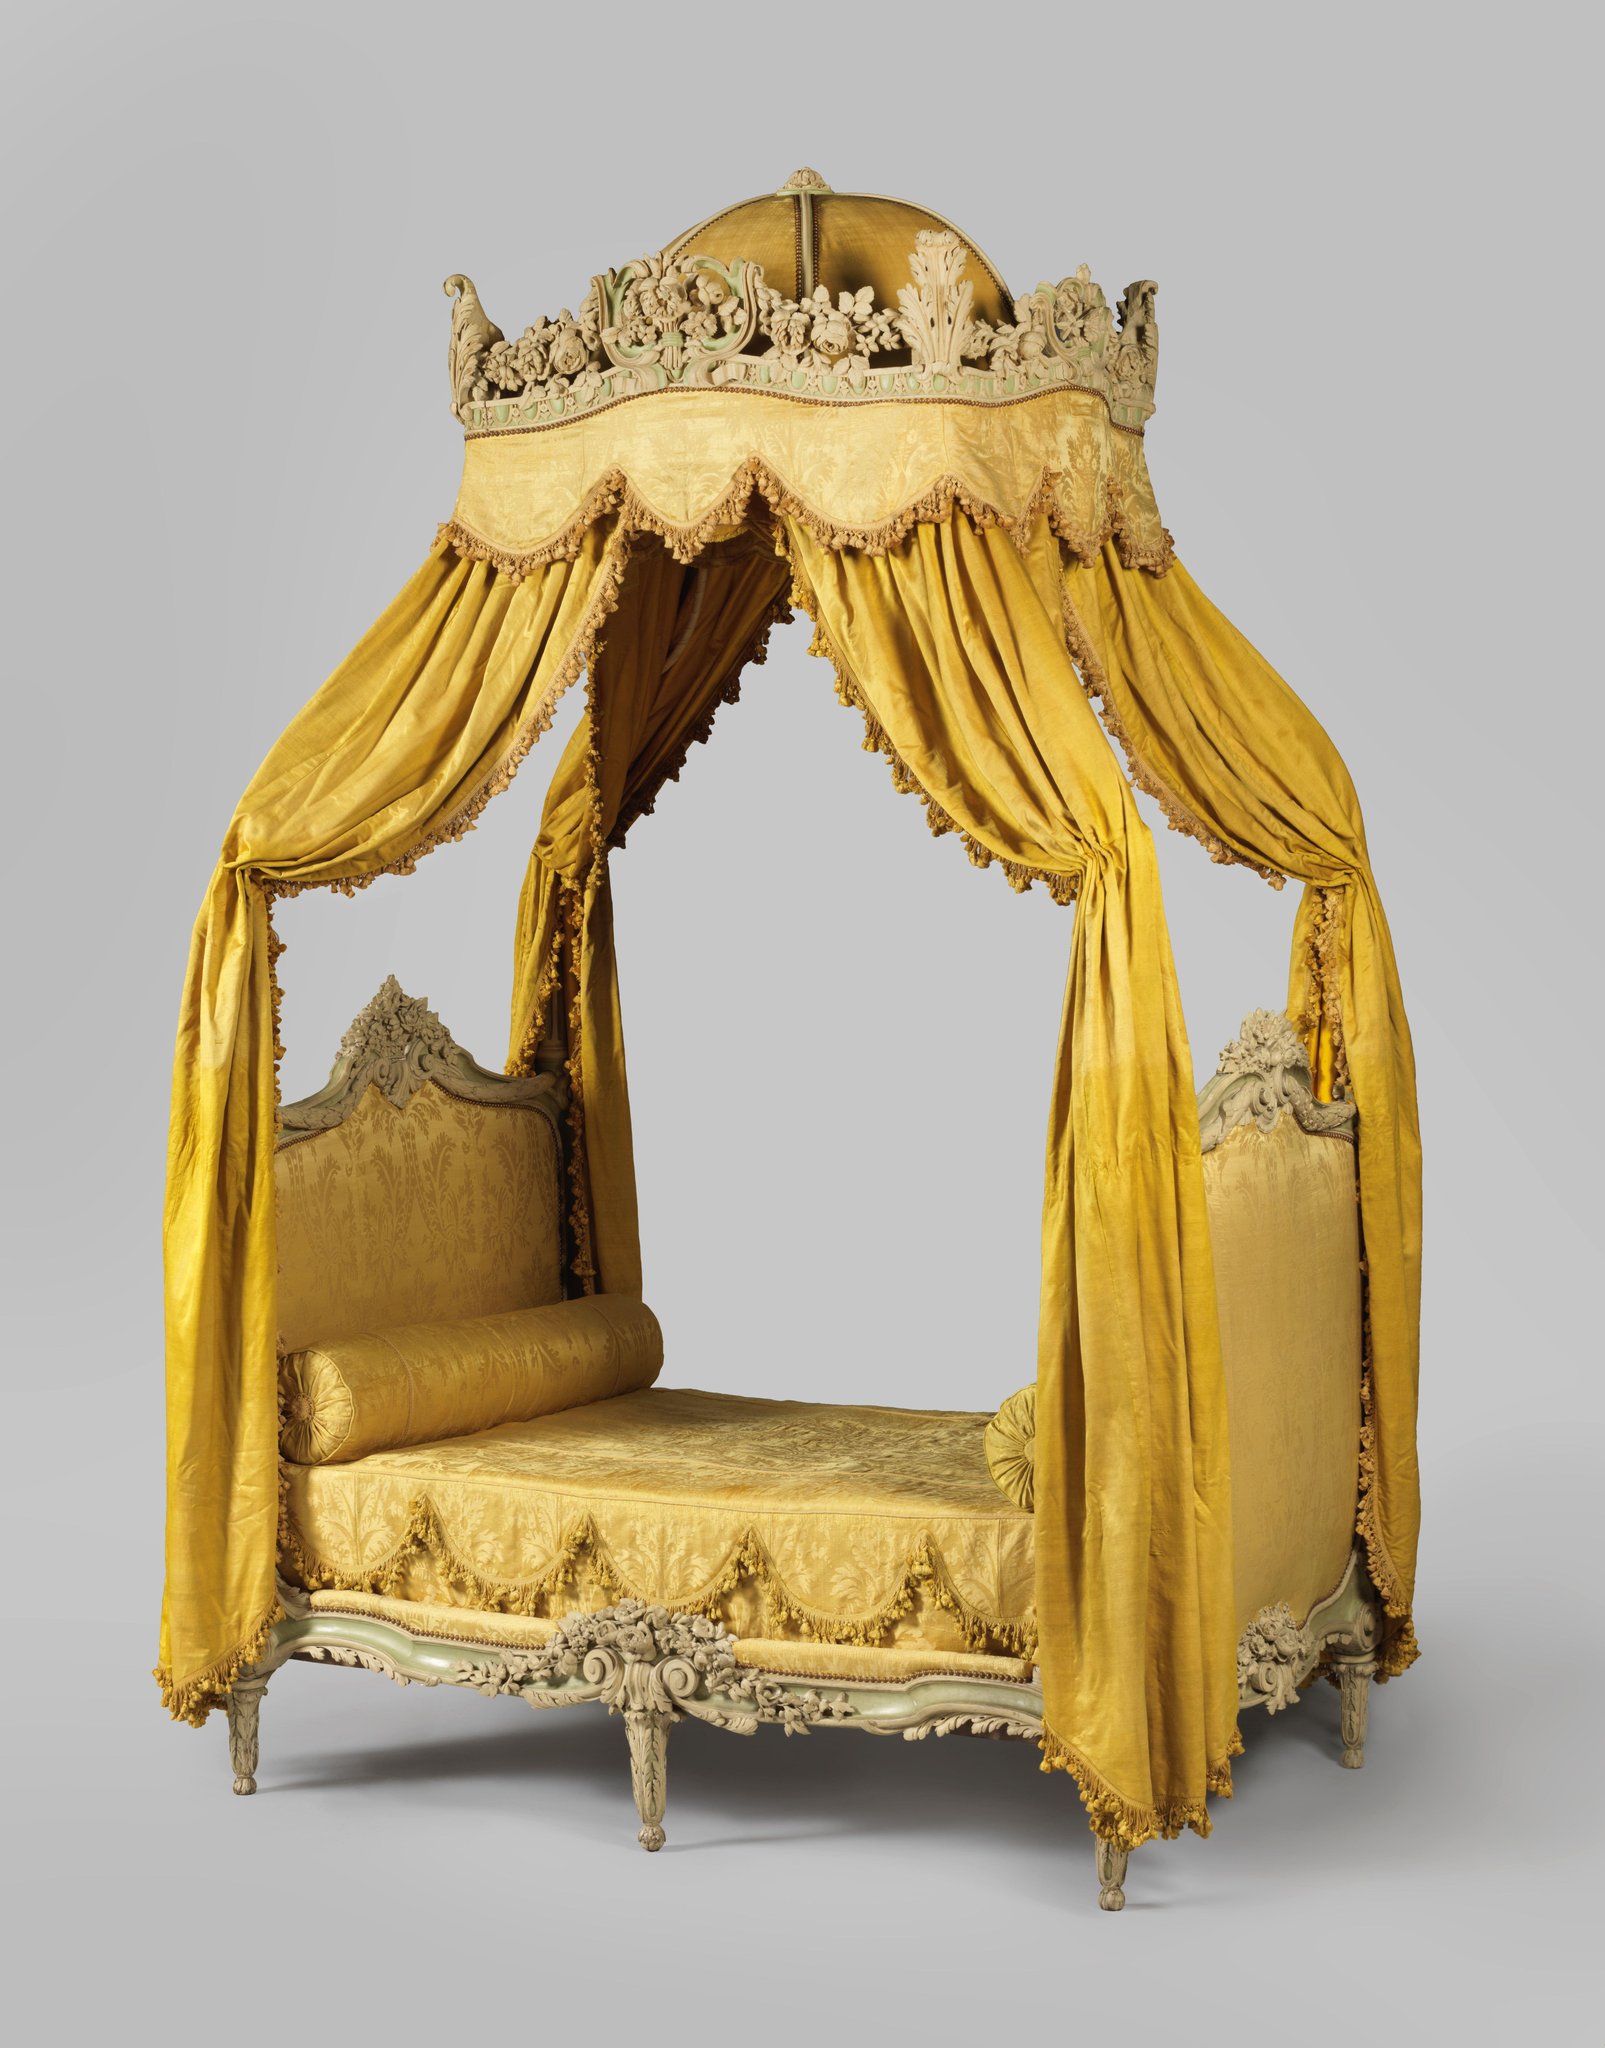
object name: ledikant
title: Lit à la Polonaise, bed van groen en grijs geschilderd beukenhout met vijf conische poten met acanthusblad, snijwerk van bloem- en bladwerk, beklede hemel en schotten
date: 1775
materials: wood, copper, iron, paint, textile, silk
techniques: cutting, damask, painted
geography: france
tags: bed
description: Bed. Beech, with later damask upholstery. Paris, c. 1775, after a design by Jean-Charles Delafosse (called Lit á la Polonaise).